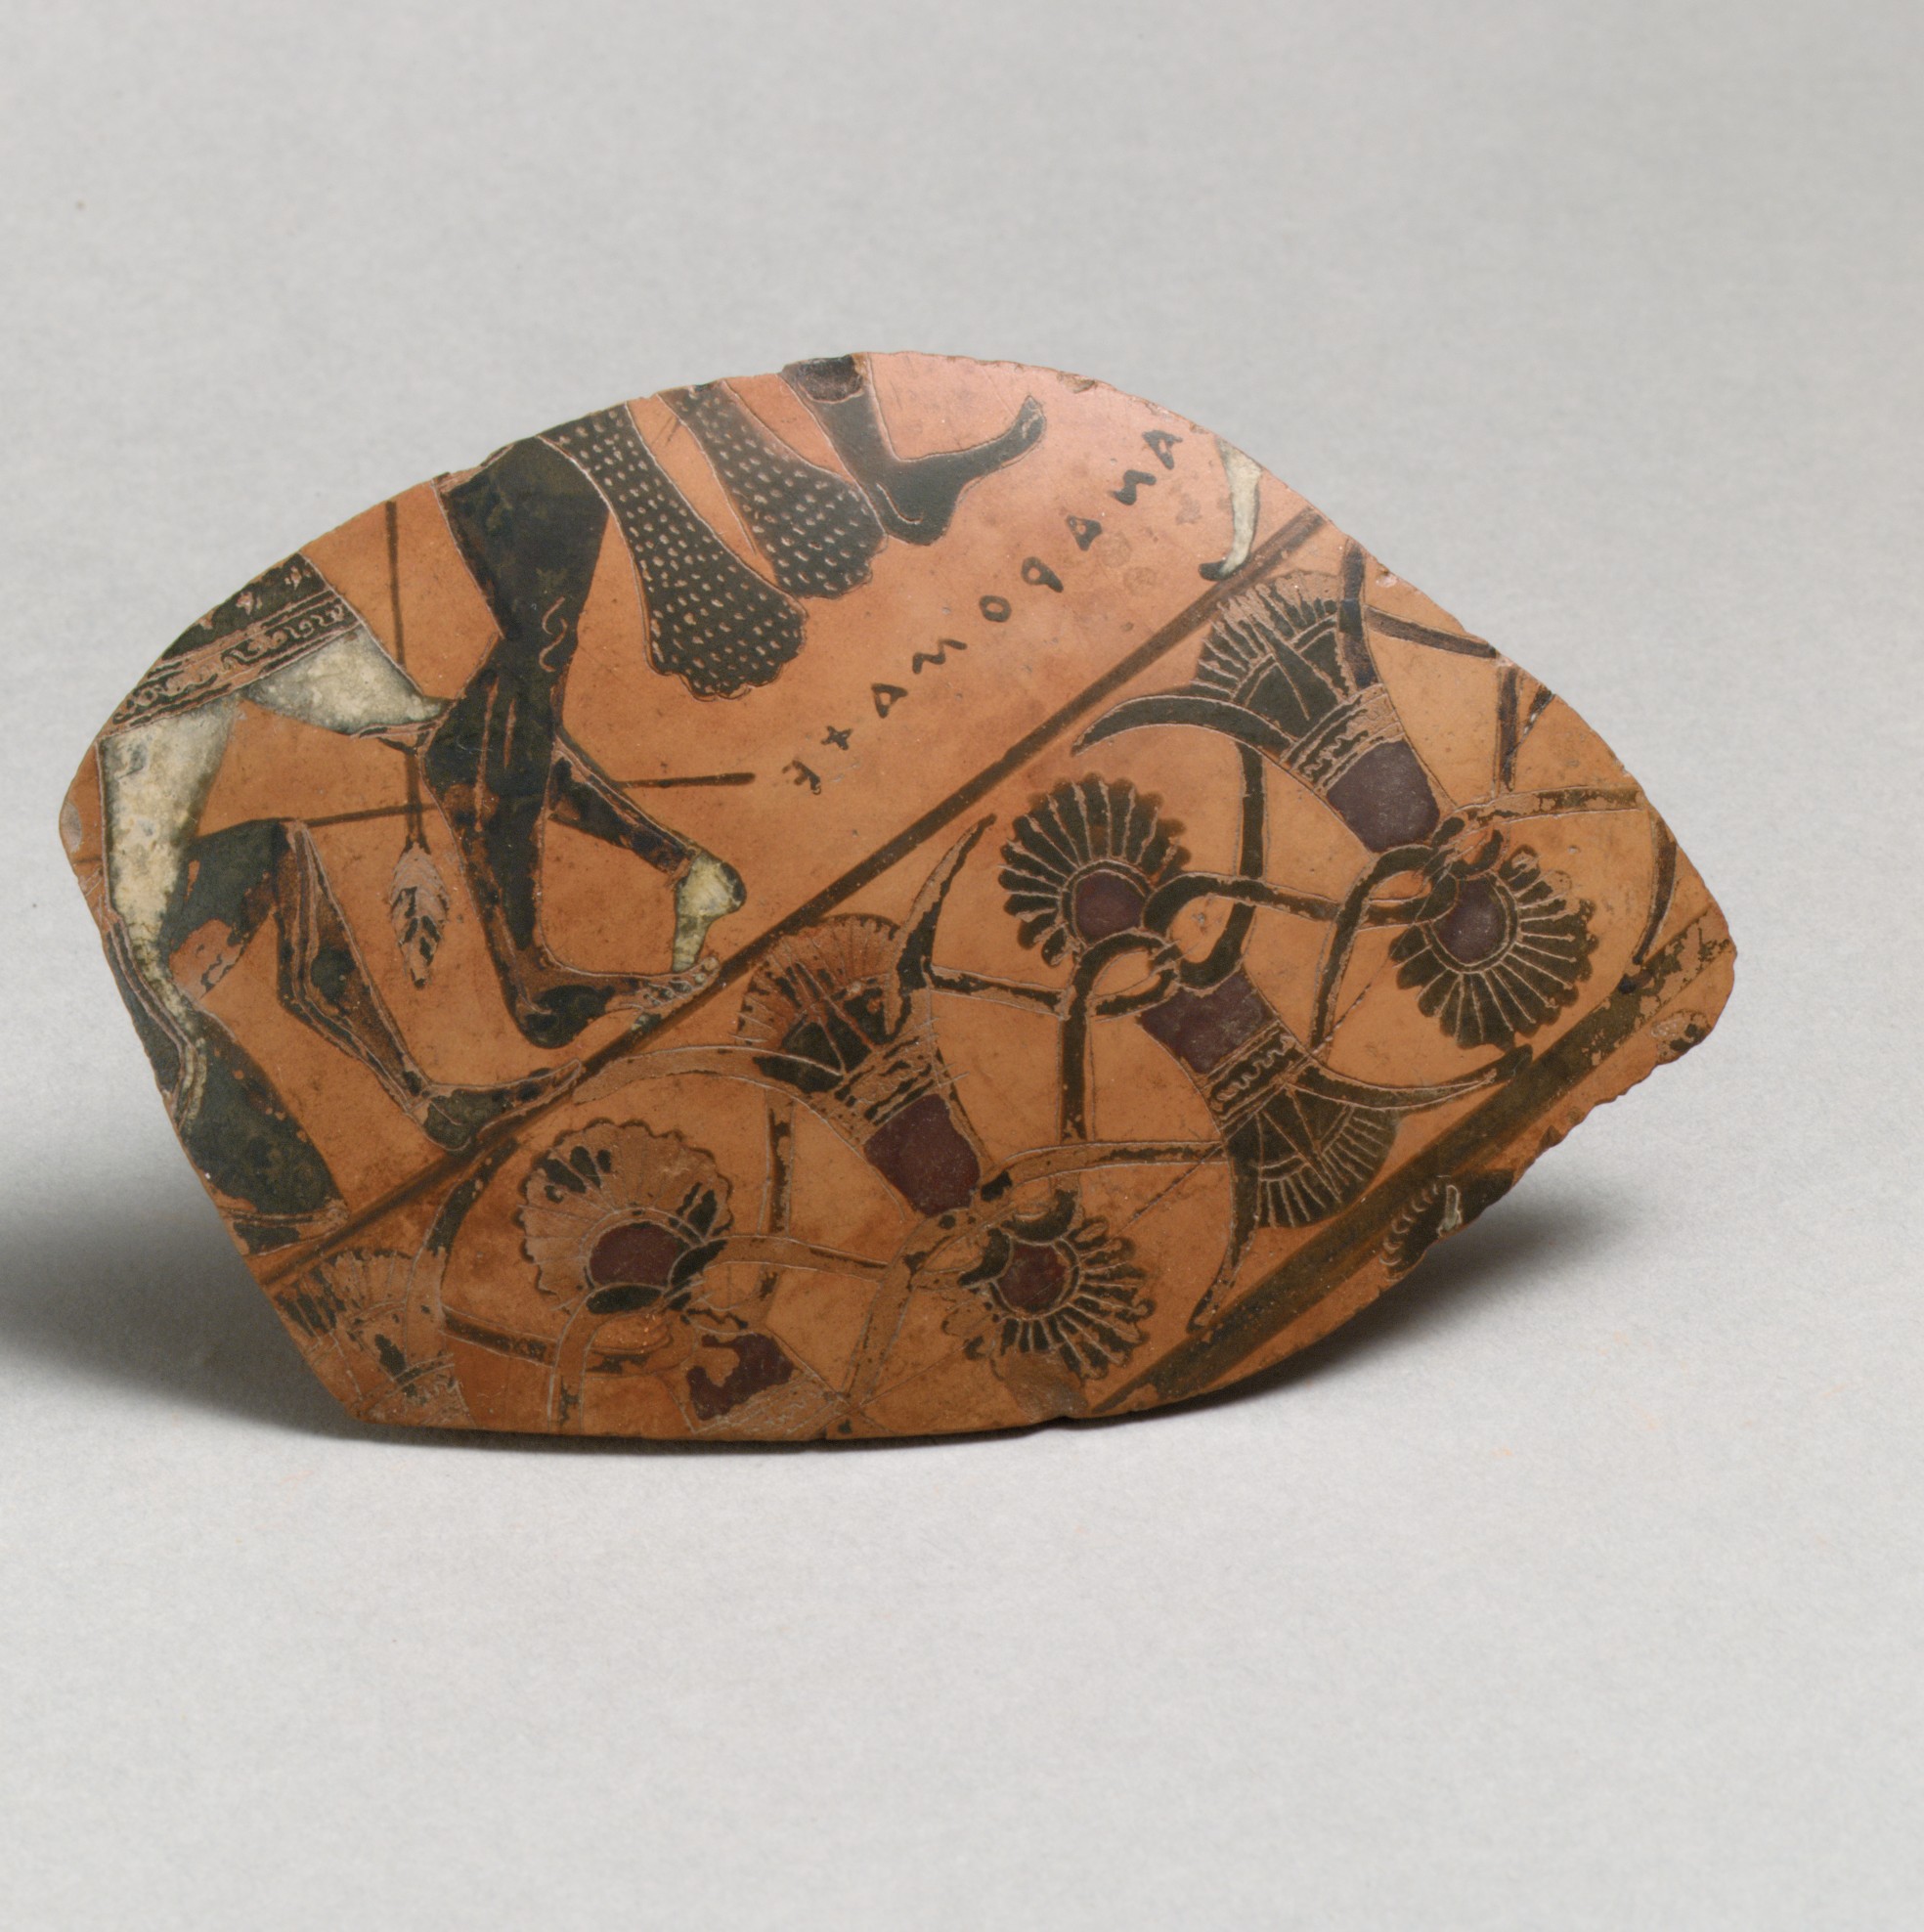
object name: neck amphora, tyrrhenian fragment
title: Fragment of a terracotta neck-amphora (jar)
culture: greek, attic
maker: prometheus painter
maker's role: artist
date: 575-560 BCE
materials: terracotta